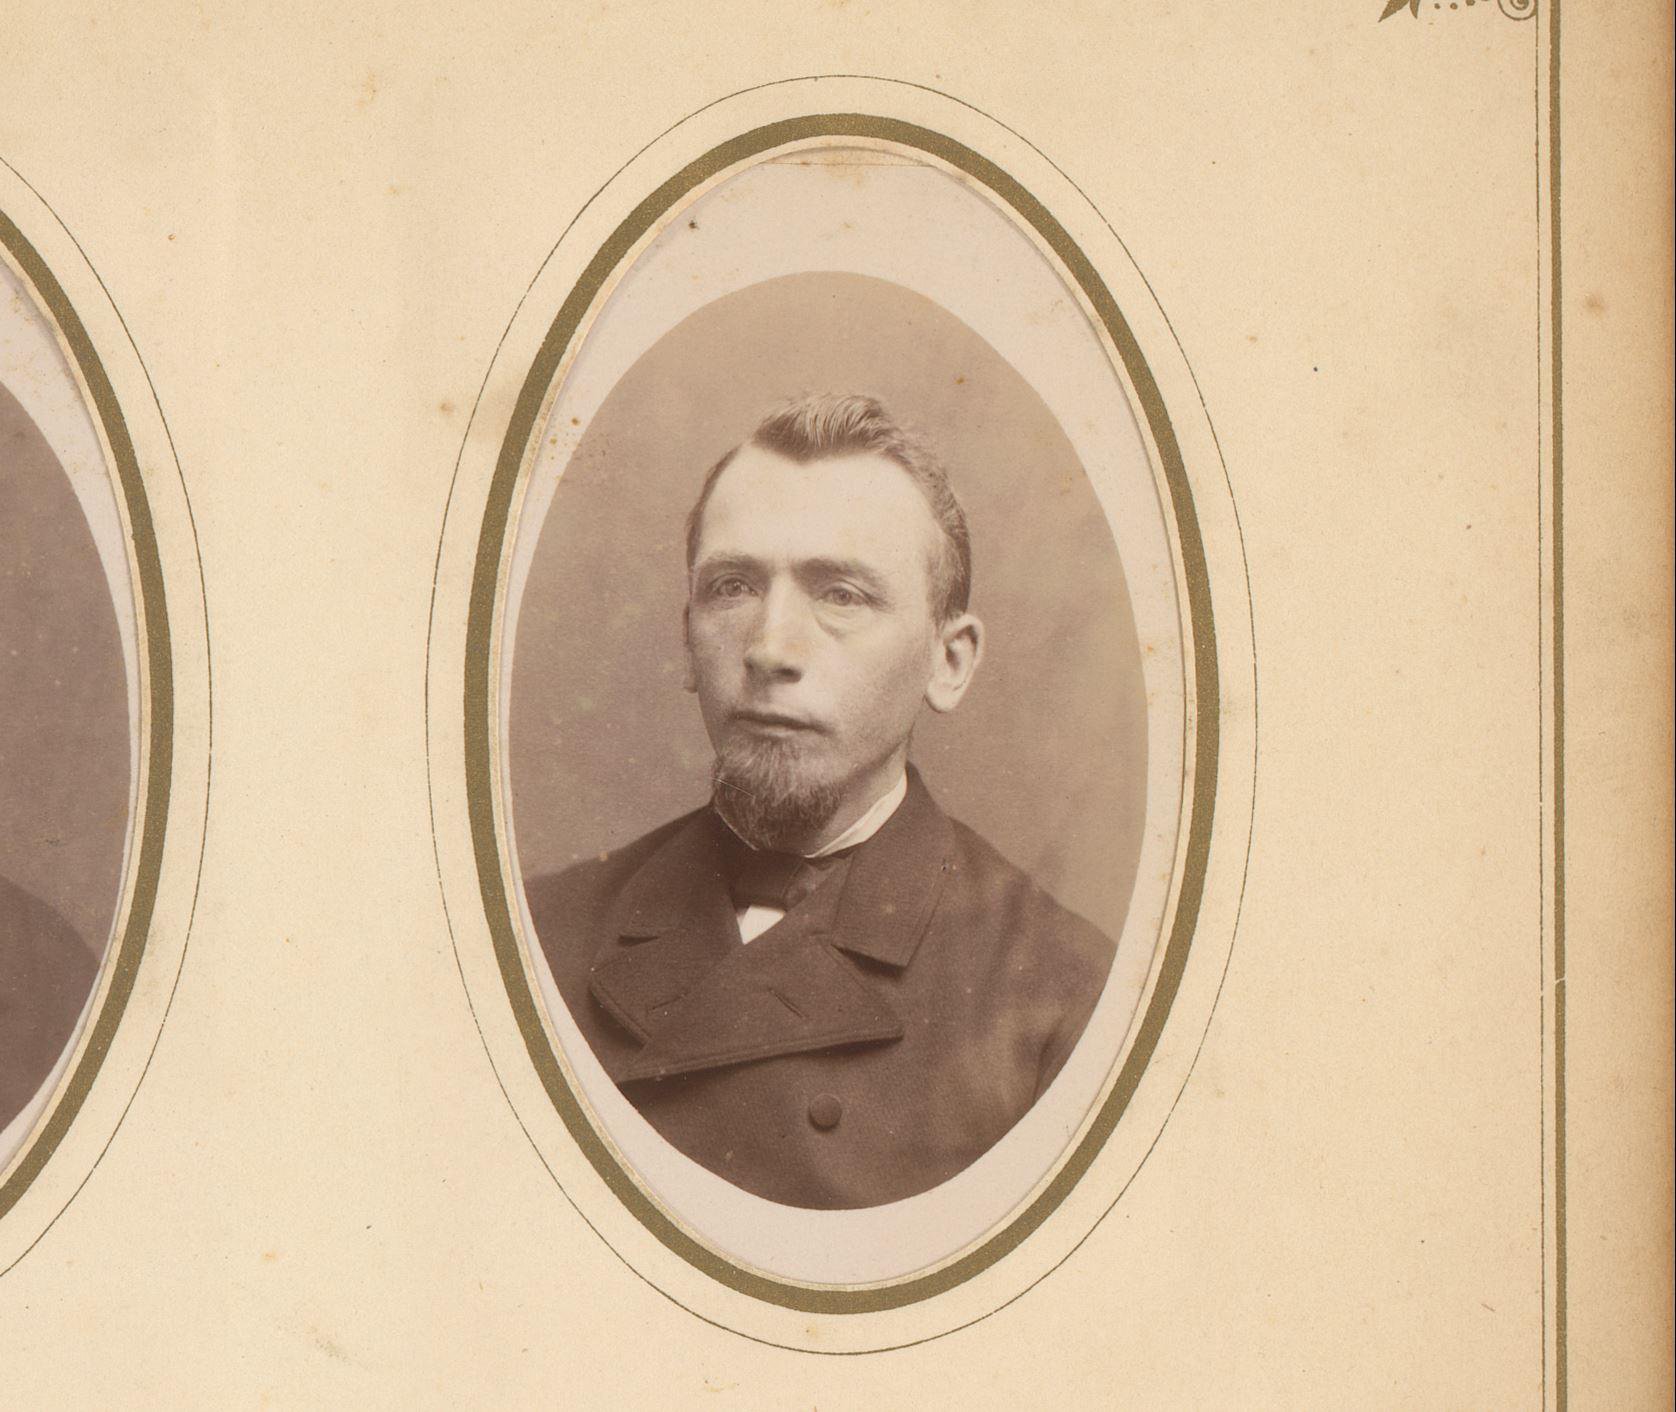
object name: album leaf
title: Portret van een man met baard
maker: hendrik johannes craije azn.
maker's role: fotograaf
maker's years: 1857-1936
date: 1879-1900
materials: cardboard, photographic support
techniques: albumen print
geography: leeuwarden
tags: historical persons, beard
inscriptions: inscription: ‘Photographie/ H. J. Craije Azn/ firma RINGLER/ Schoolstraat 9,/ Leeuwarden./ De platen blijven ter nabestelling bewaard./ Speciale Inrichting voor vergrootingen.’